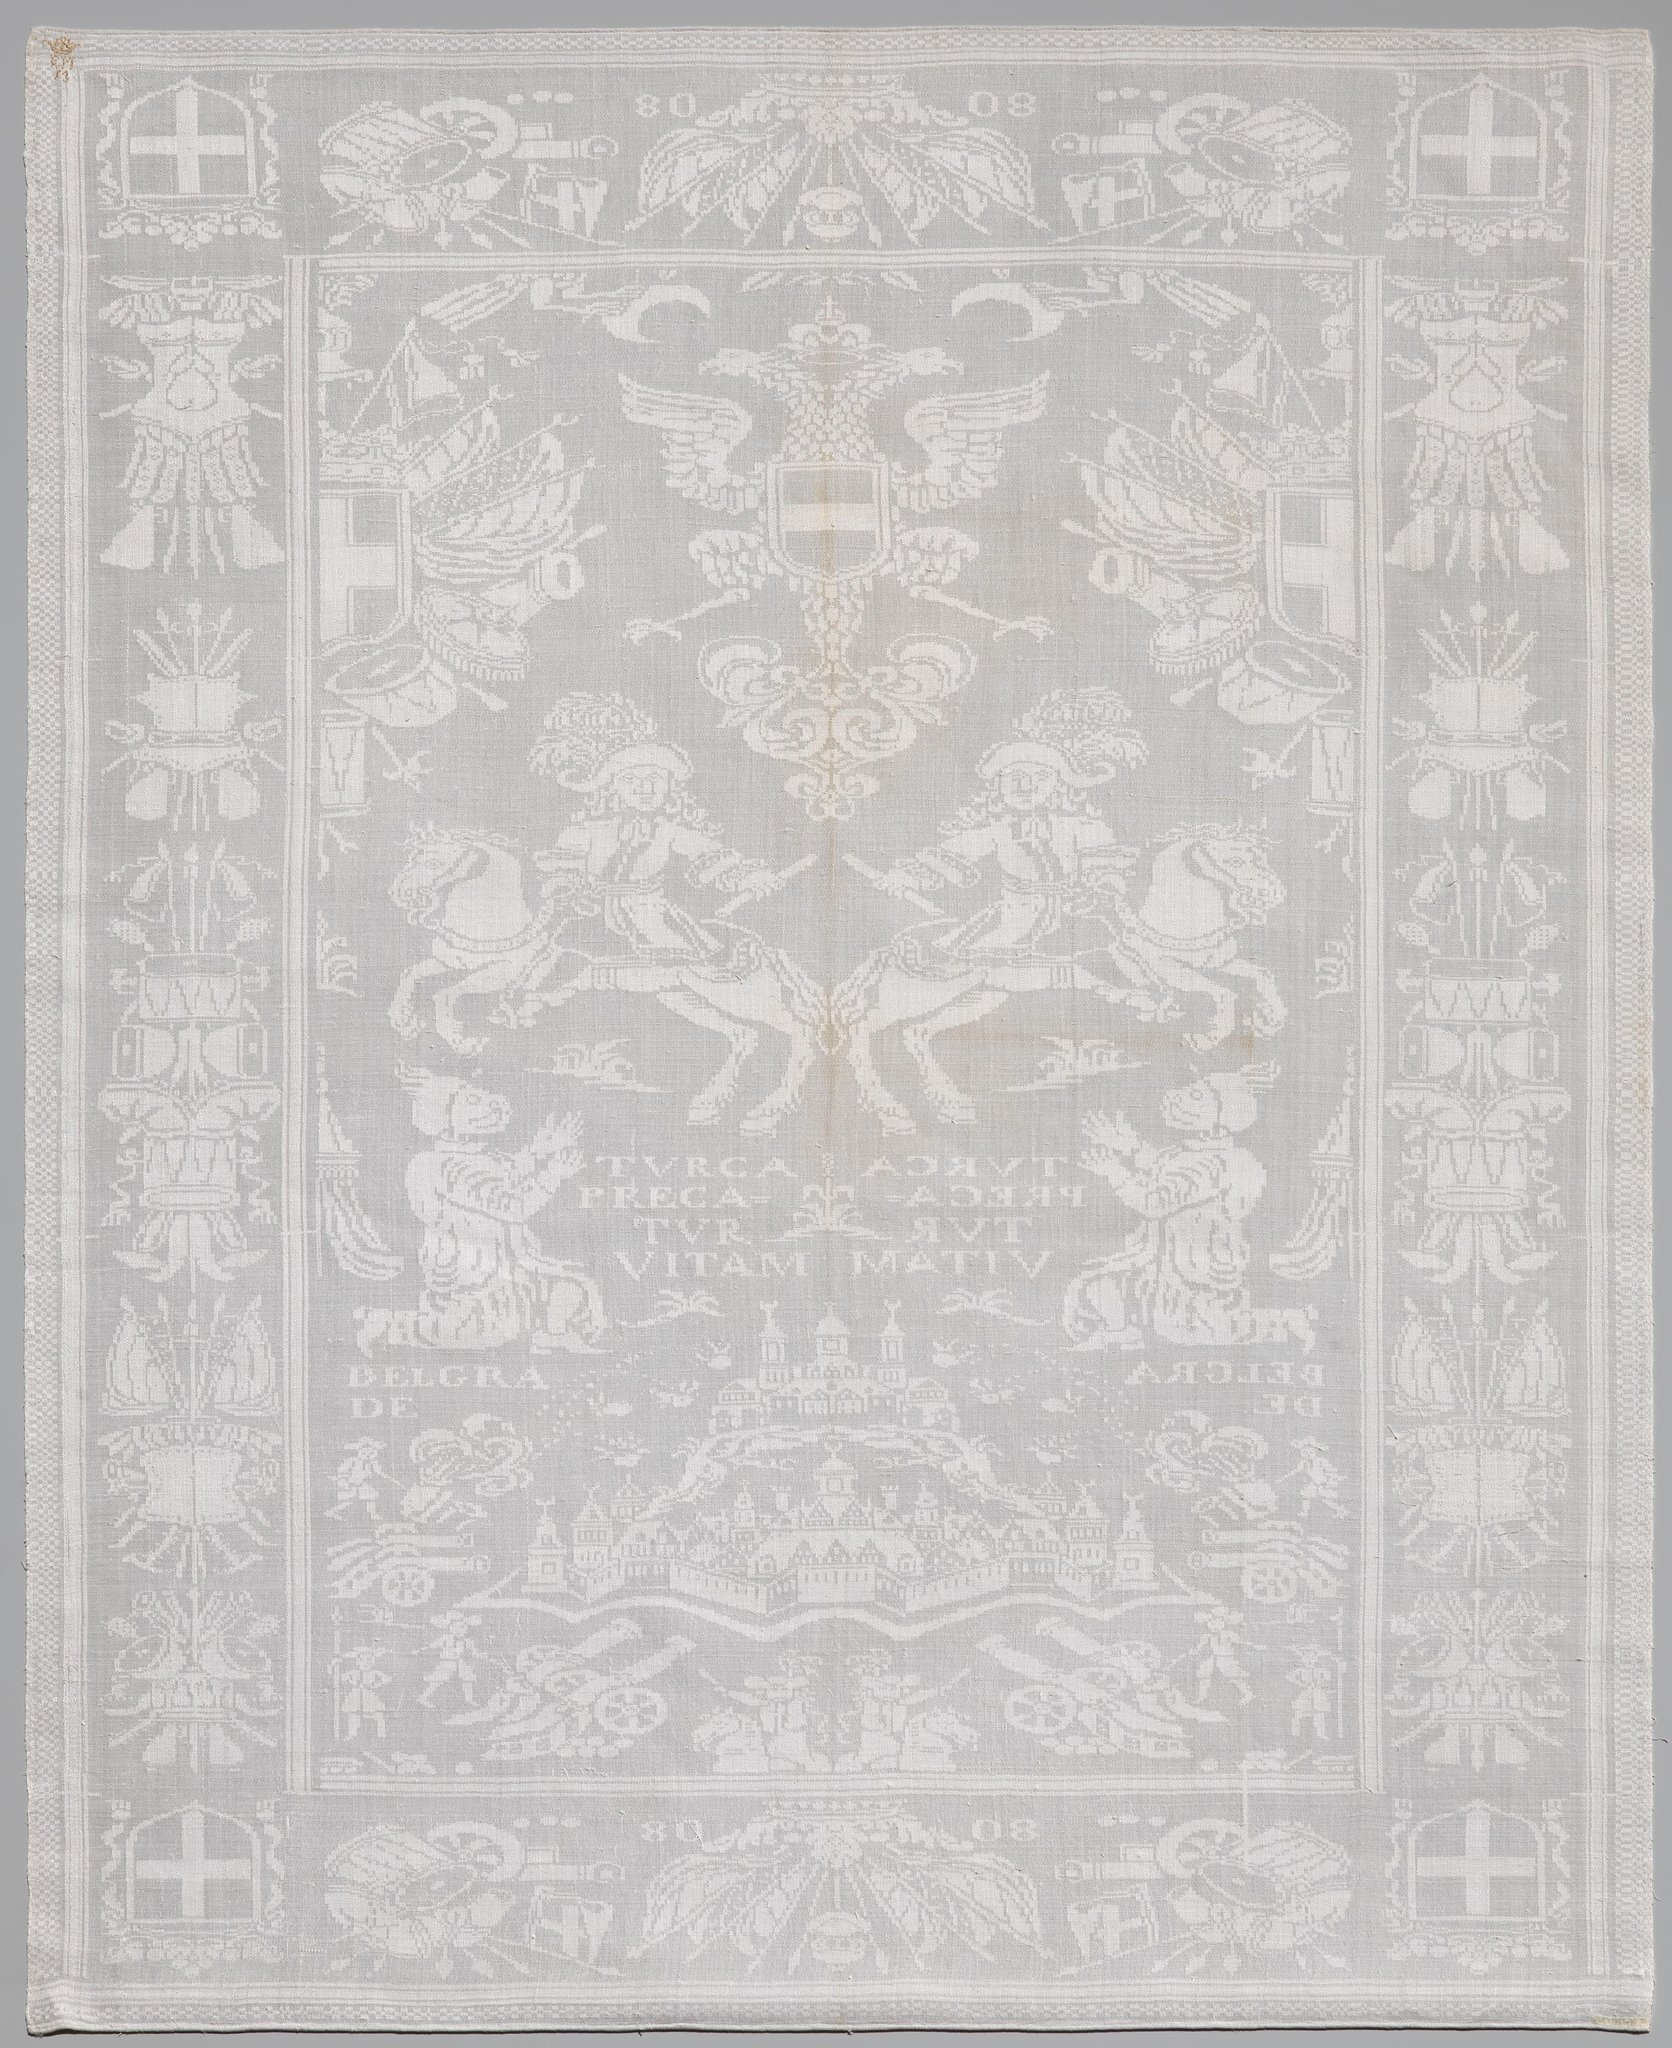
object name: napkin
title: Servet van linnendamast met een historisch tafereel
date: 1717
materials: linen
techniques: damask, weave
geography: flanders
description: Wit linnendamasten servet met de verovering van Belgrado op de Turken door Eugenius van Savoye. Gemerkt E M 13 onder een kroon. Het veld heeft een gespiegelde afbeelding met van onder naam boven: mannen bij kanonnen, een stad en opschrift BELGRADE een knielende man en opschrift TVRCA PRECA TVR VITAM, een ruiter en twee halve wapens. De randen hebben wapentrofeeën en de hoeken een wapen.